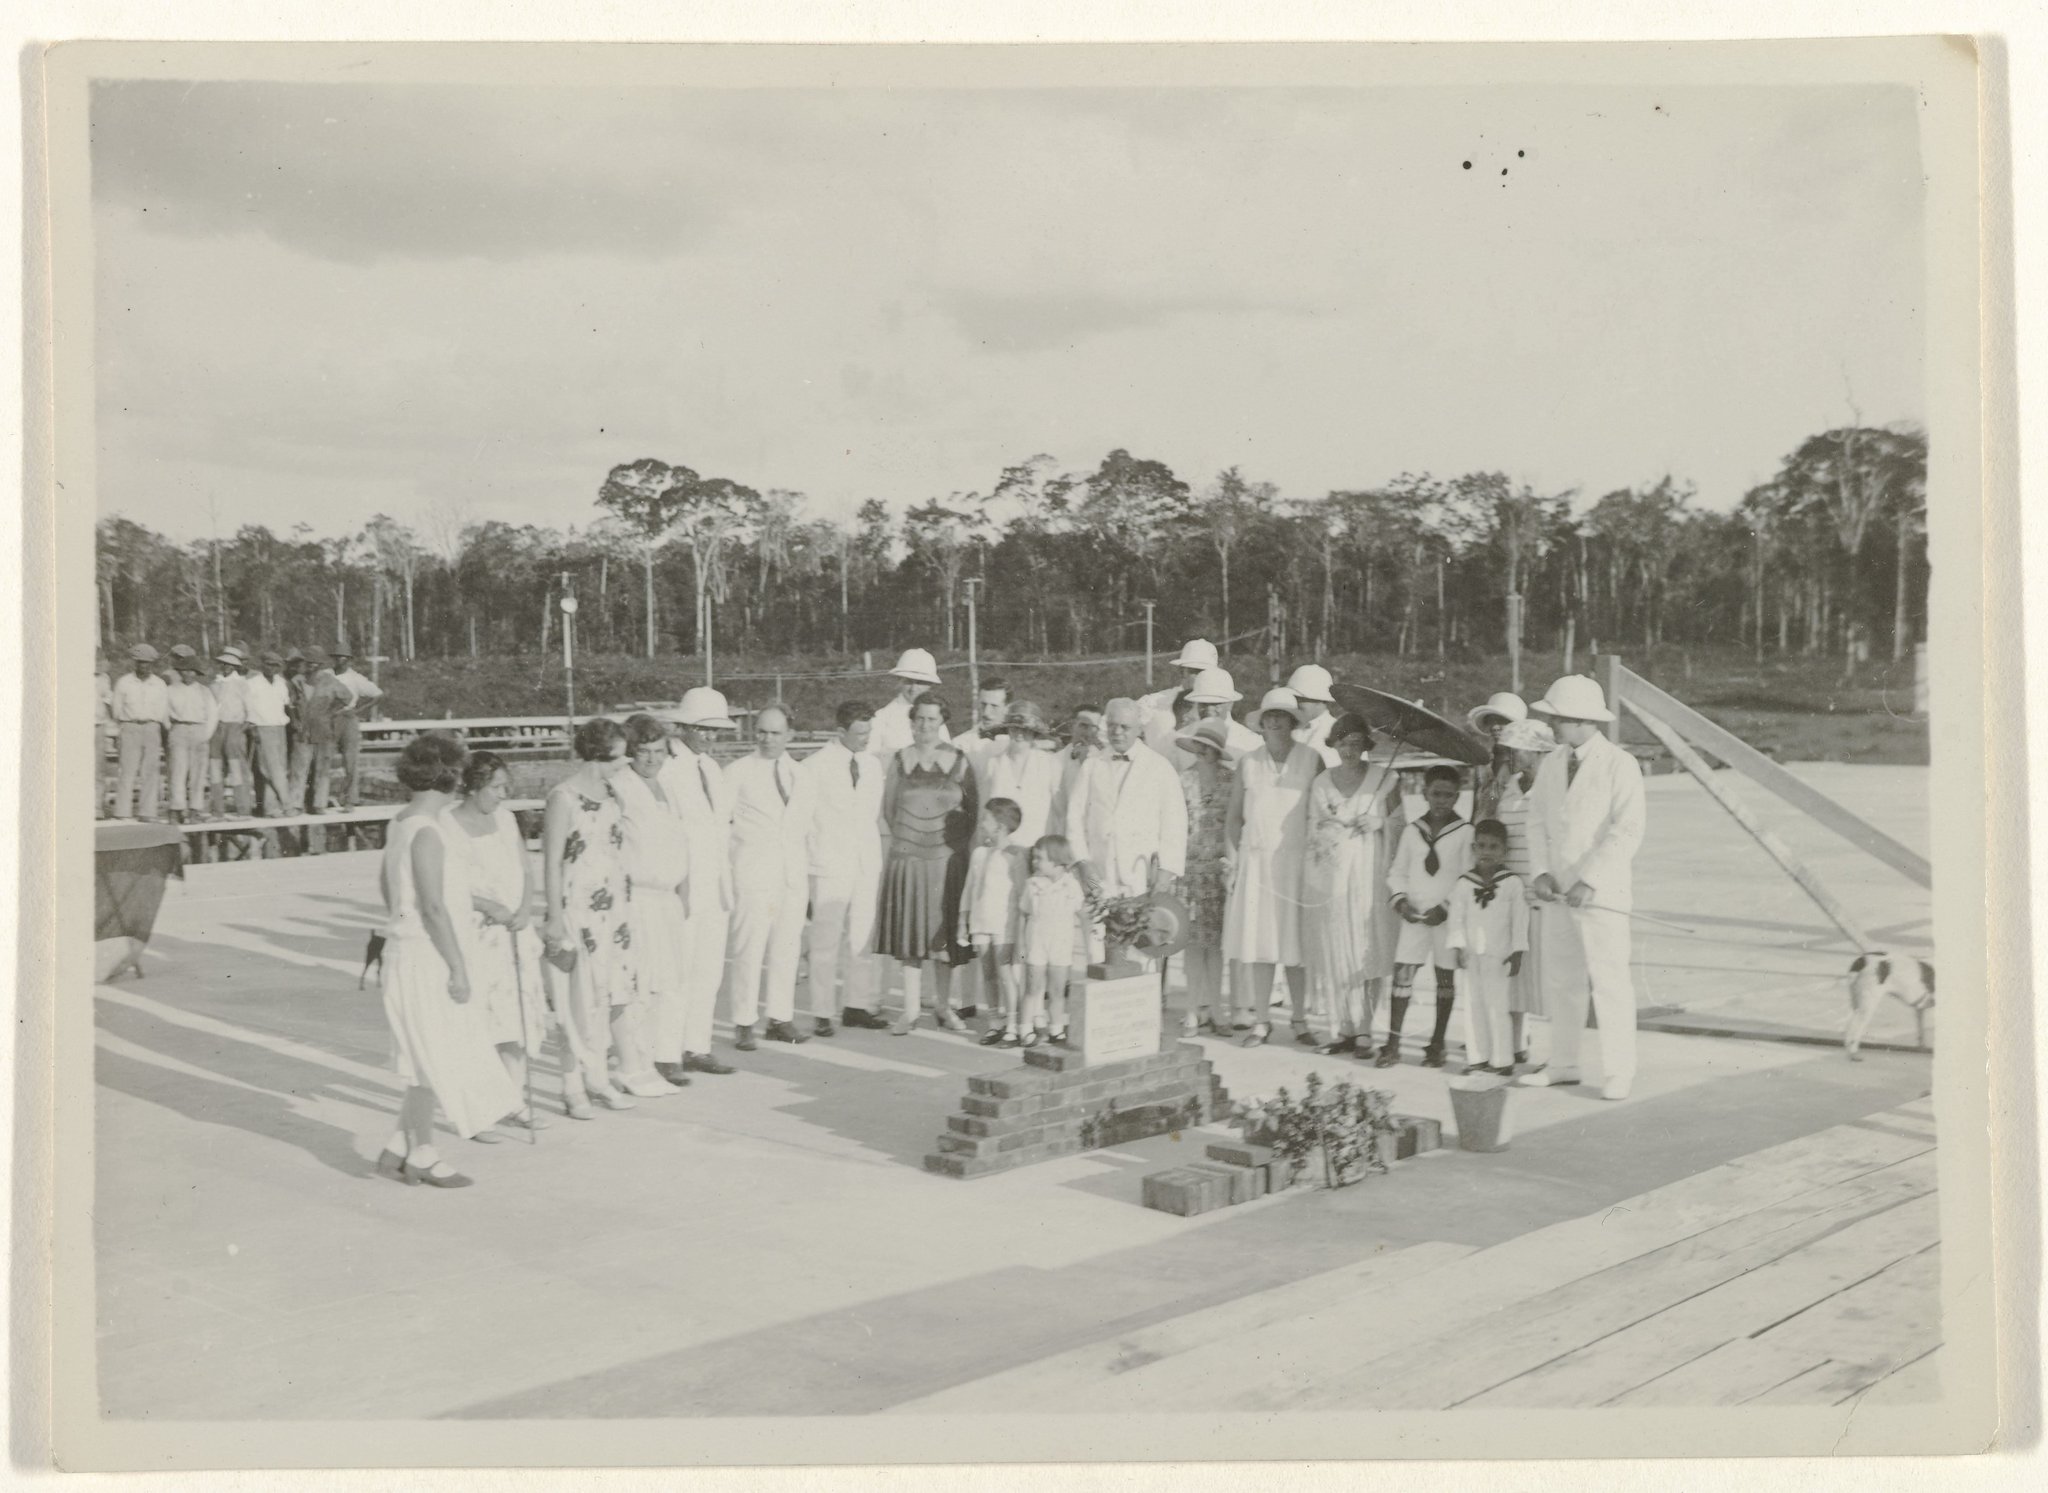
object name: photograph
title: Eerste steenlegging van het ziekenhuis in Moengo.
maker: Anonymous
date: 1929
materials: photographic support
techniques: photography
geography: suriname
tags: hospital, ceremonial laying of the foundations, laying the first stone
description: Eerste steenlegging van het ziekenhuis in Moengo. De oude heer in het midden met hoed in de hand is de directeur van de bauxietonderneming: ingenieur De Munnick